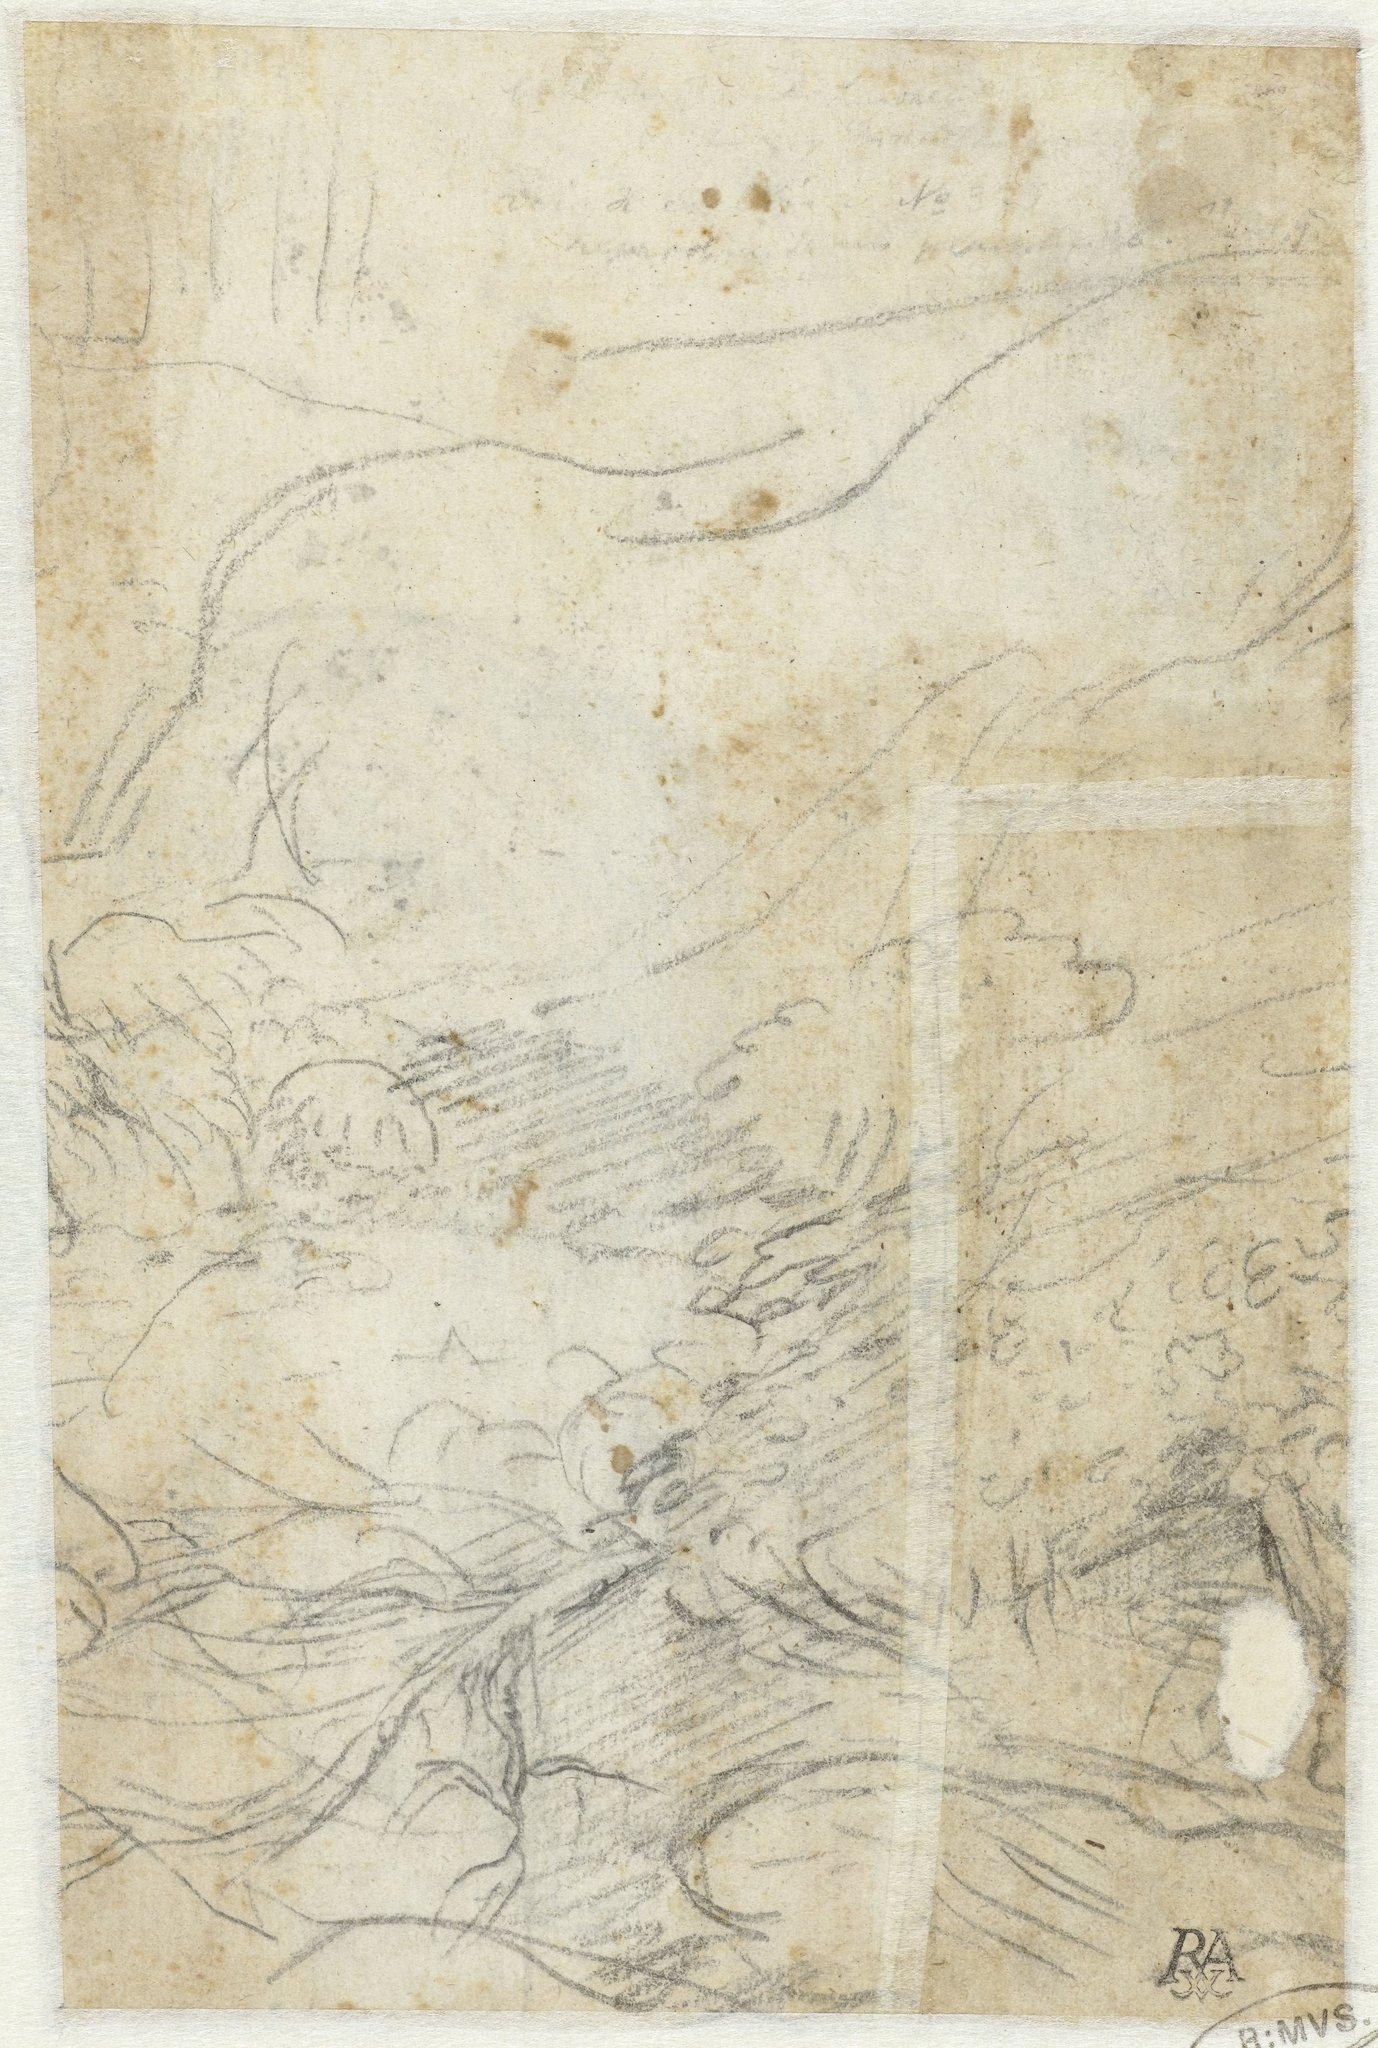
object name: drawing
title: Fragment van een berglandschap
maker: federico barocci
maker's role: draughtsman, painter, print maker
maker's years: 1528-1612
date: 1545-1612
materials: chalk, paper